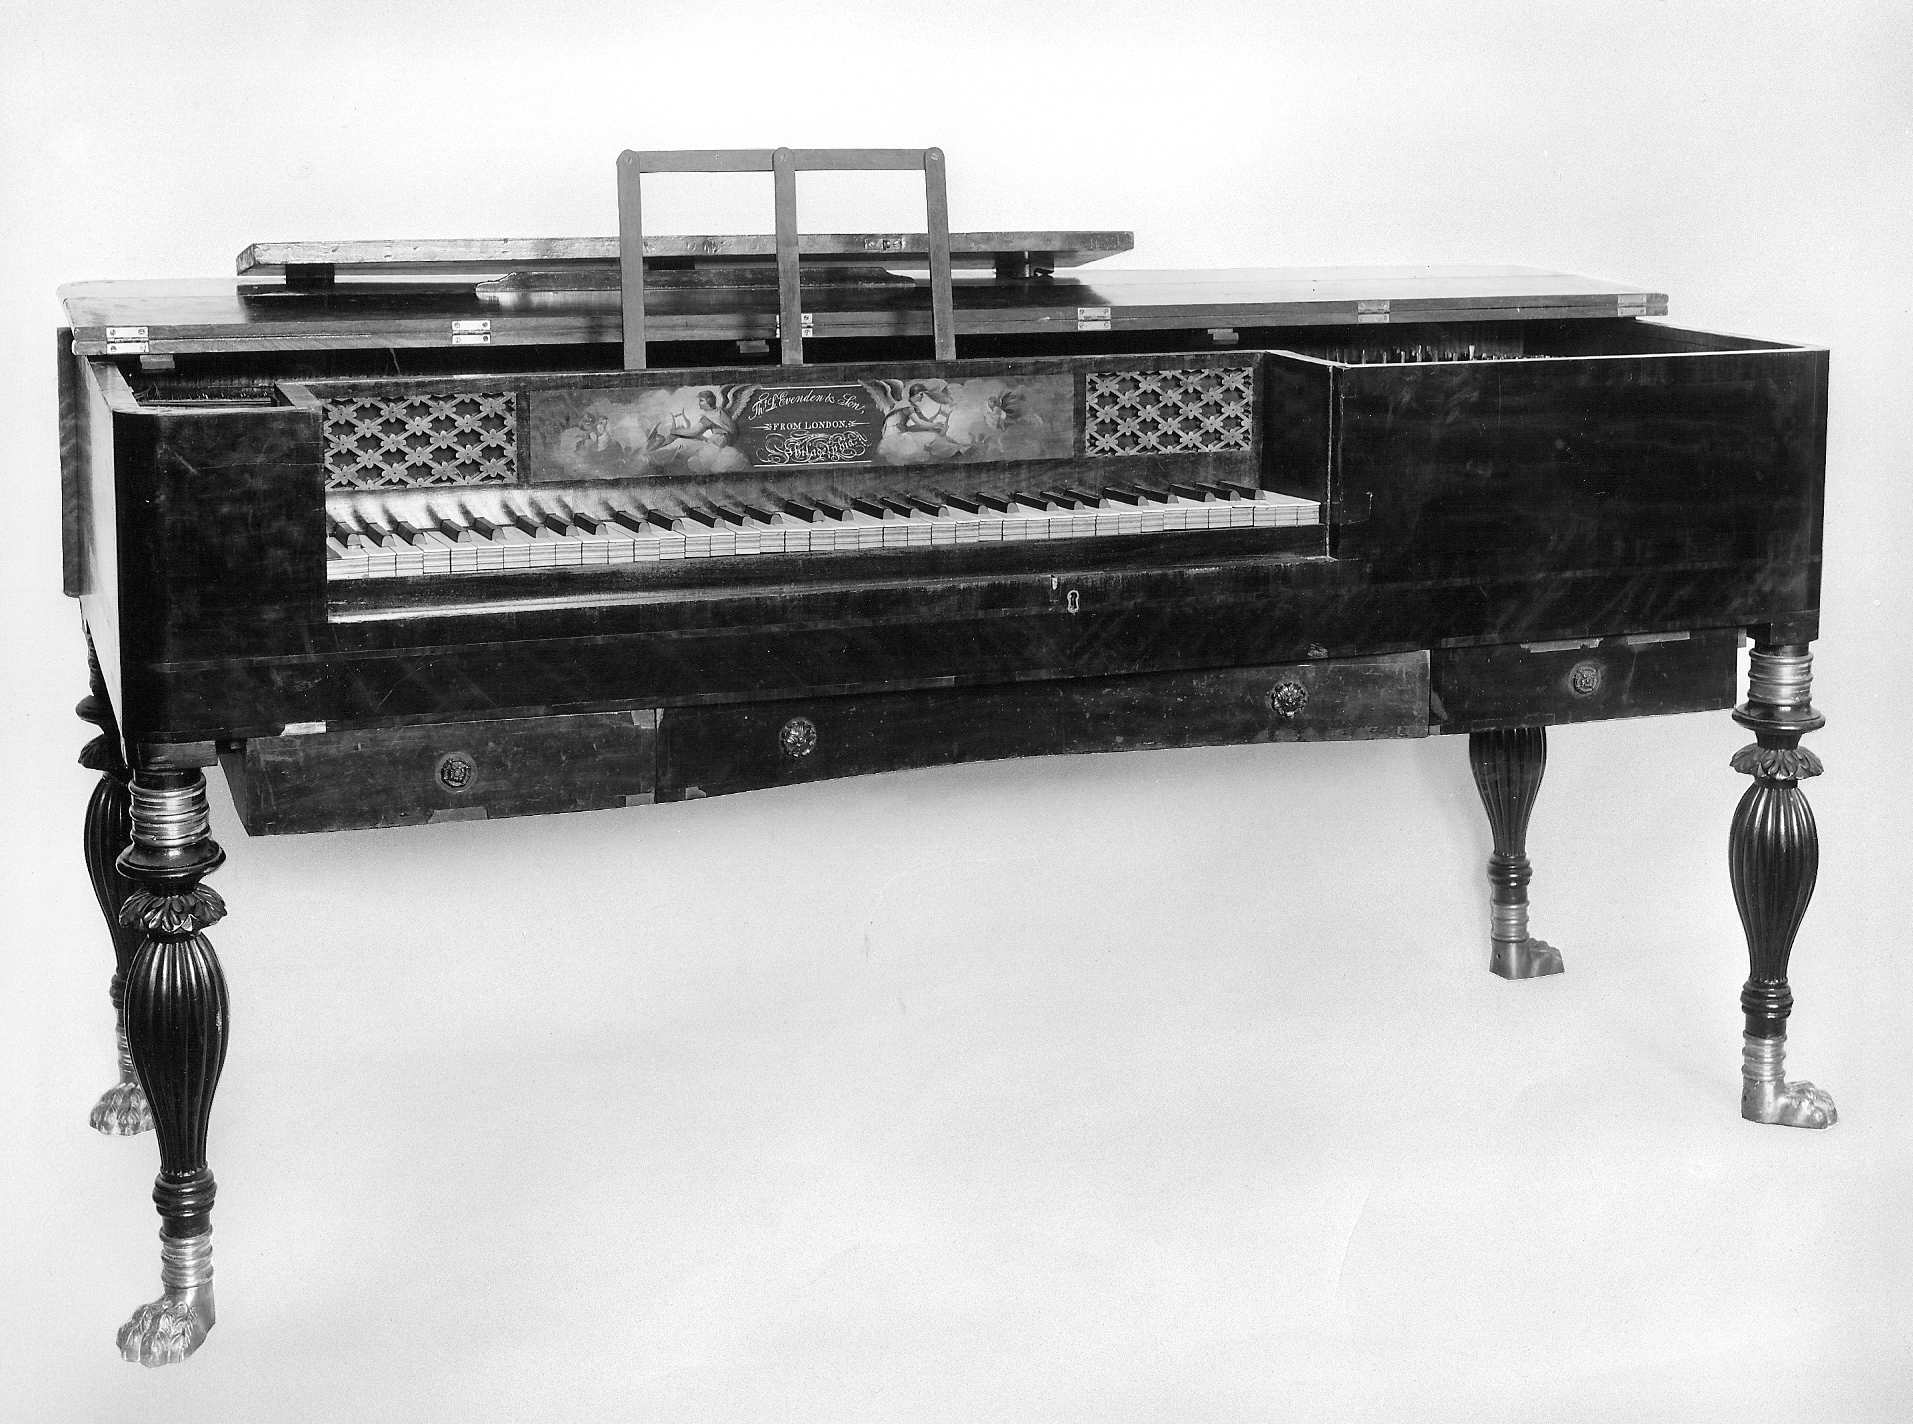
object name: square piano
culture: american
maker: thomas evenden loud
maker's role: manufacturer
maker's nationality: british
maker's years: 1792-1866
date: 1815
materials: brass, wood, ivory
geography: united states